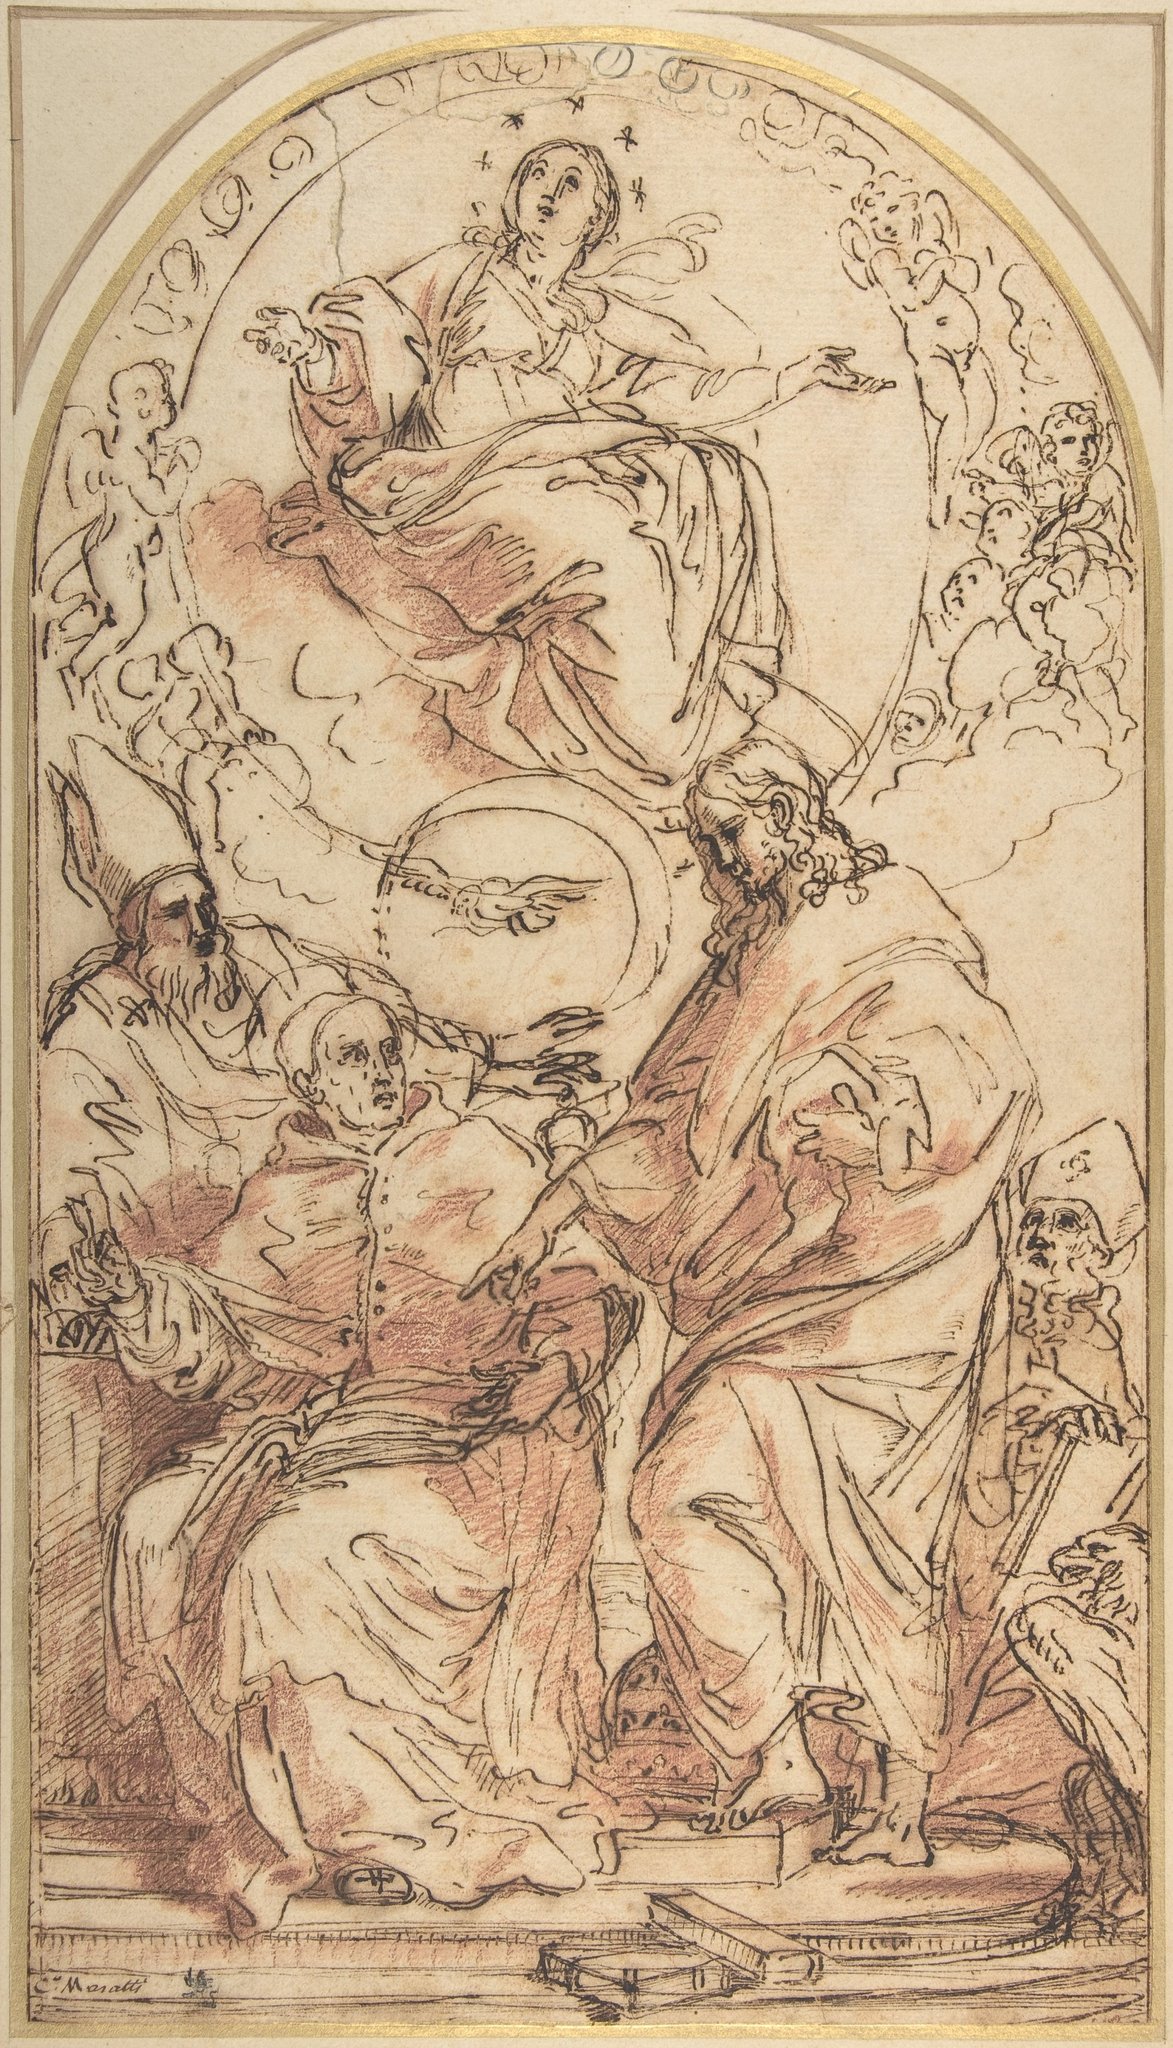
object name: drawing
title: The Virgin Immaculate with the Four Doctors of the Church, Study for the Dispute over the Immaculate Conception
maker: carlo maratti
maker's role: artist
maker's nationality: italian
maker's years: 1625-1713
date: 1625-1713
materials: chalk, ink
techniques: brush, pen, wash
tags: men,angels,virgin mary,doctors